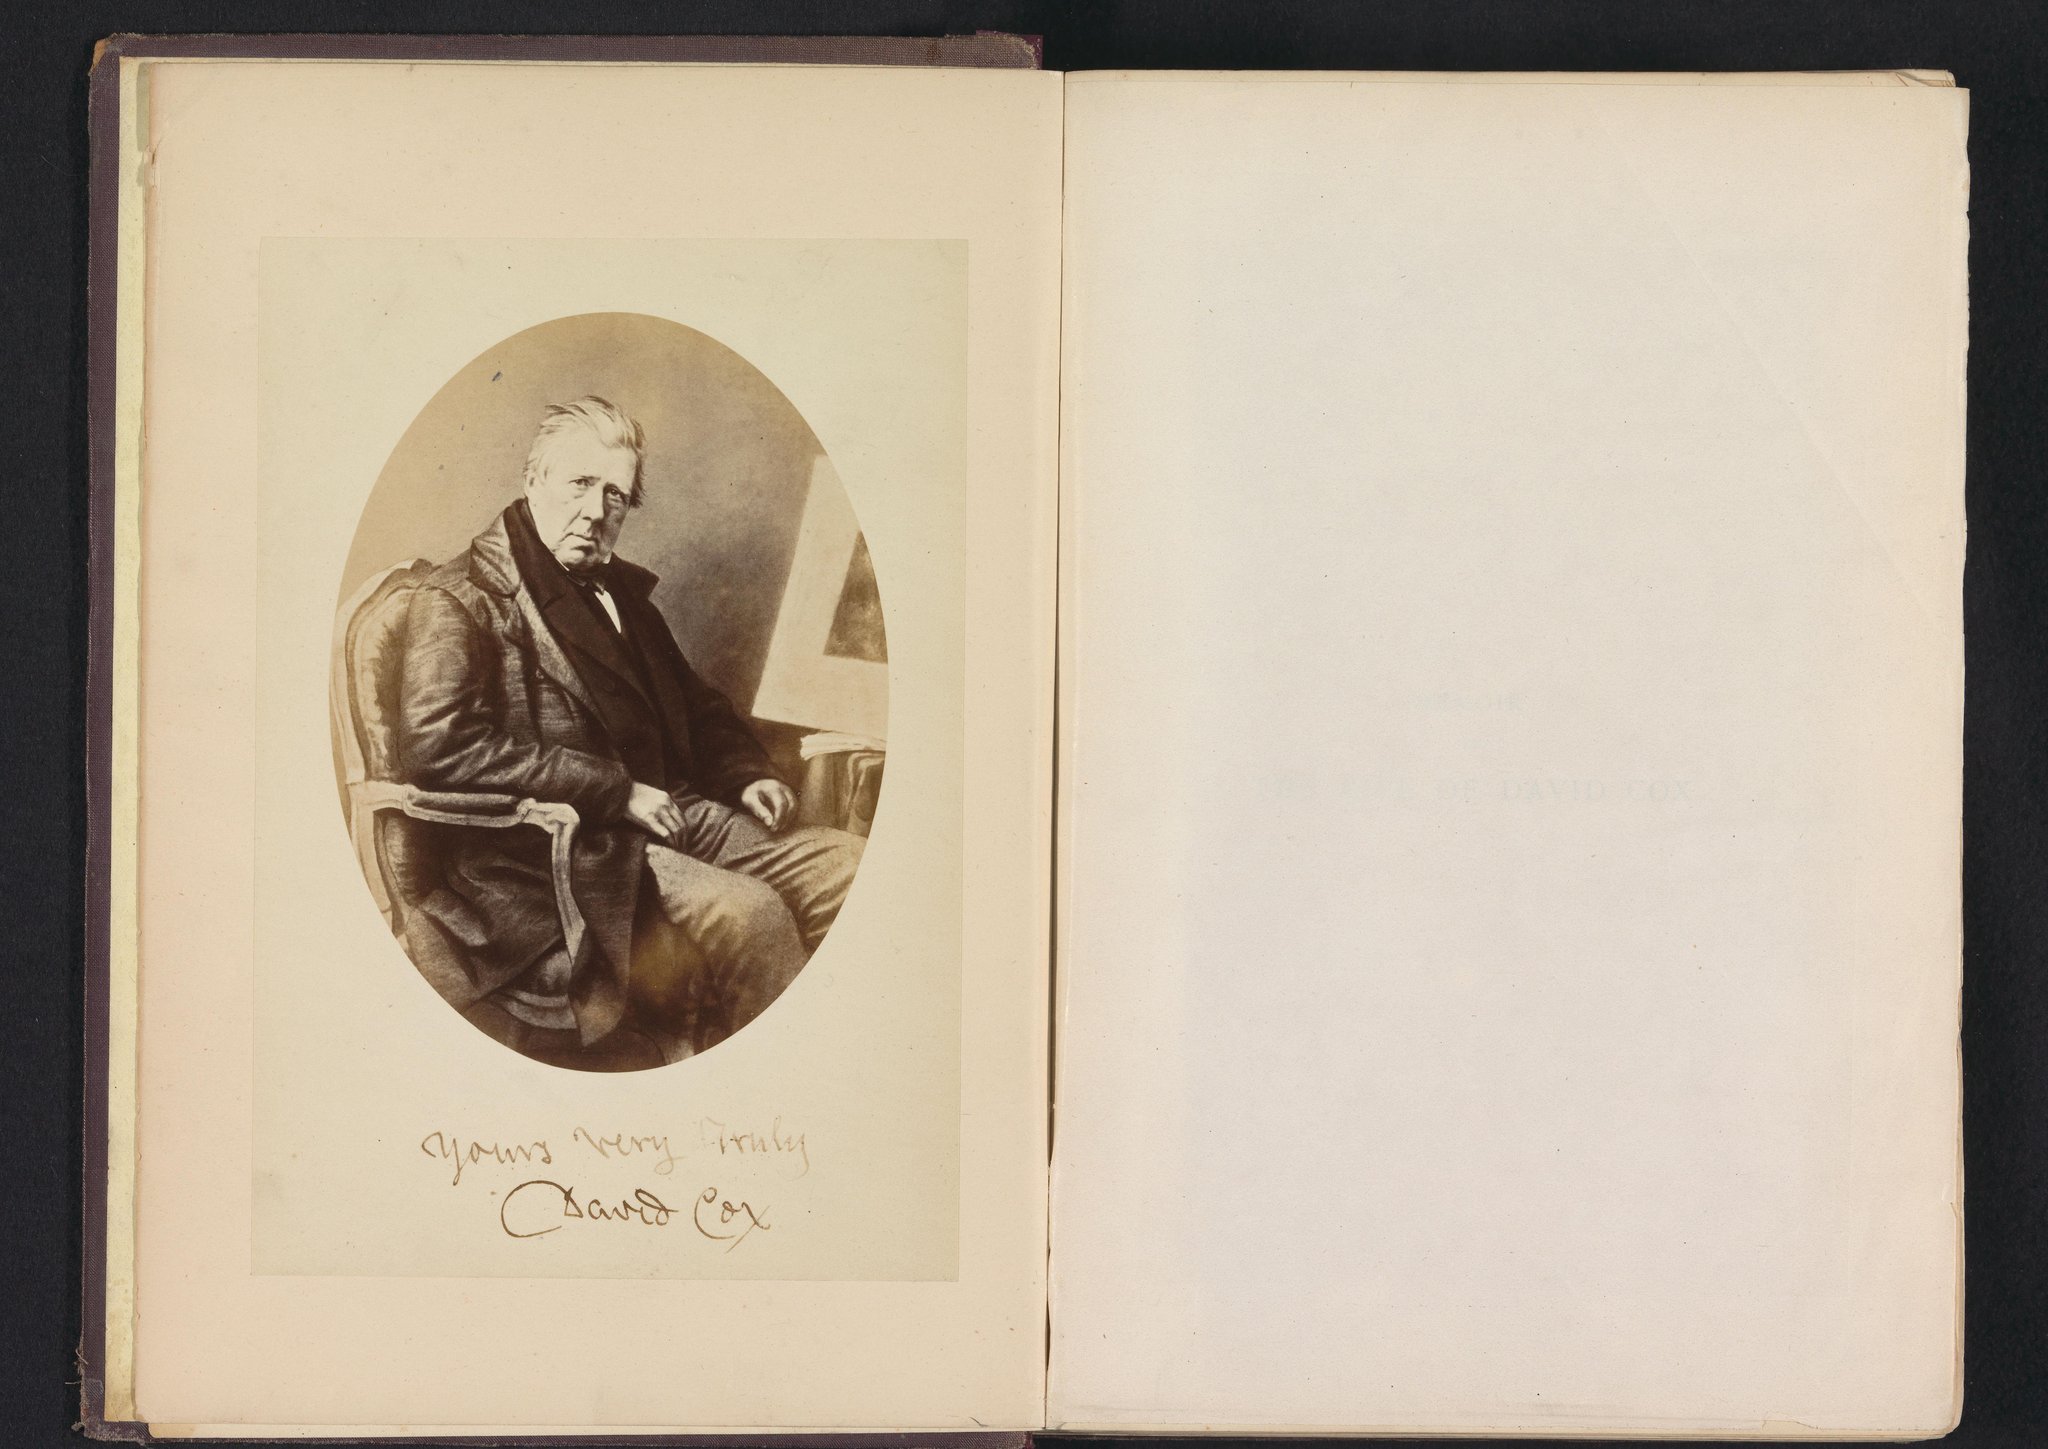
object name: page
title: Portret van David Cox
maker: Anonymous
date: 1855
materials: photographic support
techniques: albumen print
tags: draughtsman, david cox (i), portrait, self-portrait of painter